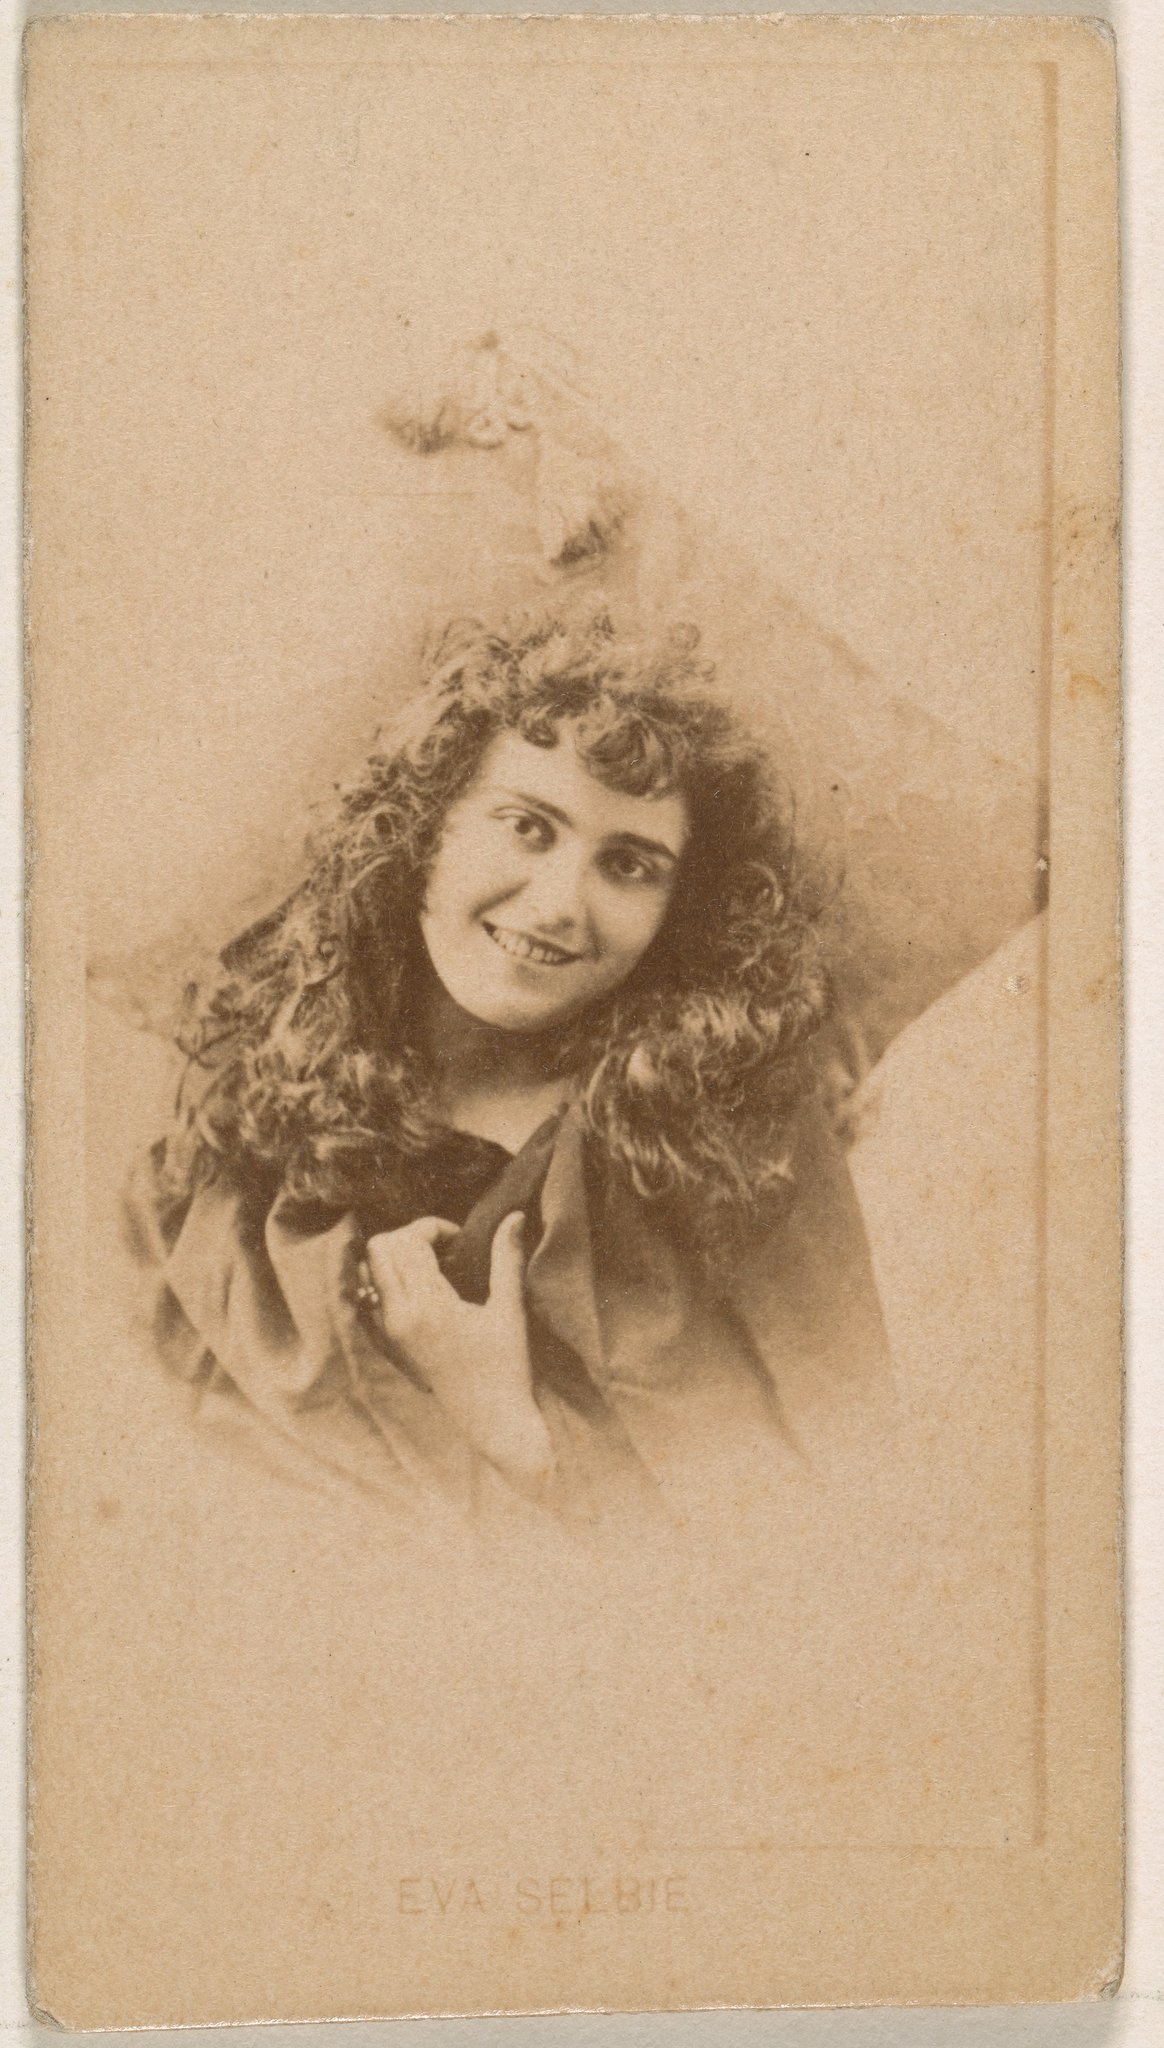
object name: photograph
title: Eva Selbie, from the Actresses series (N245) issued by Kinney Brothers to promote Sweet Caporal Cigarettes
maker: kinney brothers tobacco company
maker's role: publisher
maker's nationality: american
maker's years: 1869-2011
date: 1890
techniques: albumen silver print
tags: portraits,women,actresses